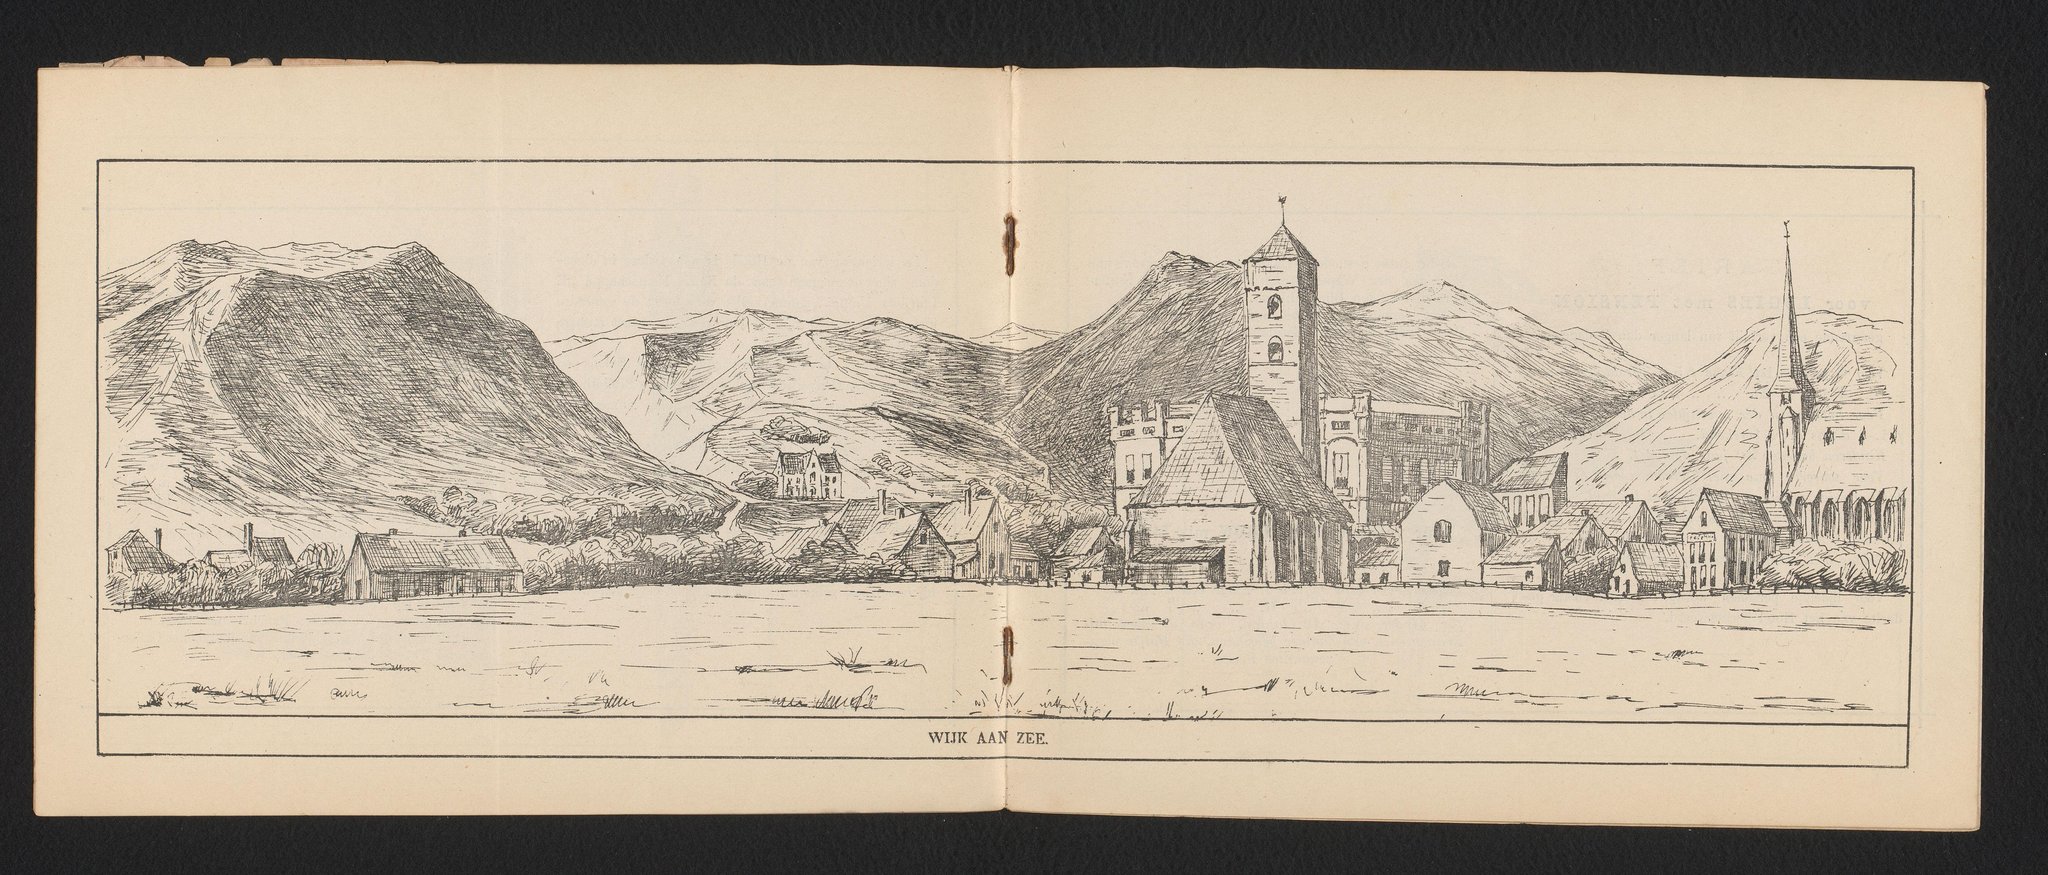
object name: print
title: Wijk aan Zee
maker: Anonymous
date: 1893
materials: paper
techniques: lithograph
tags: prospect of village, silhouette of village